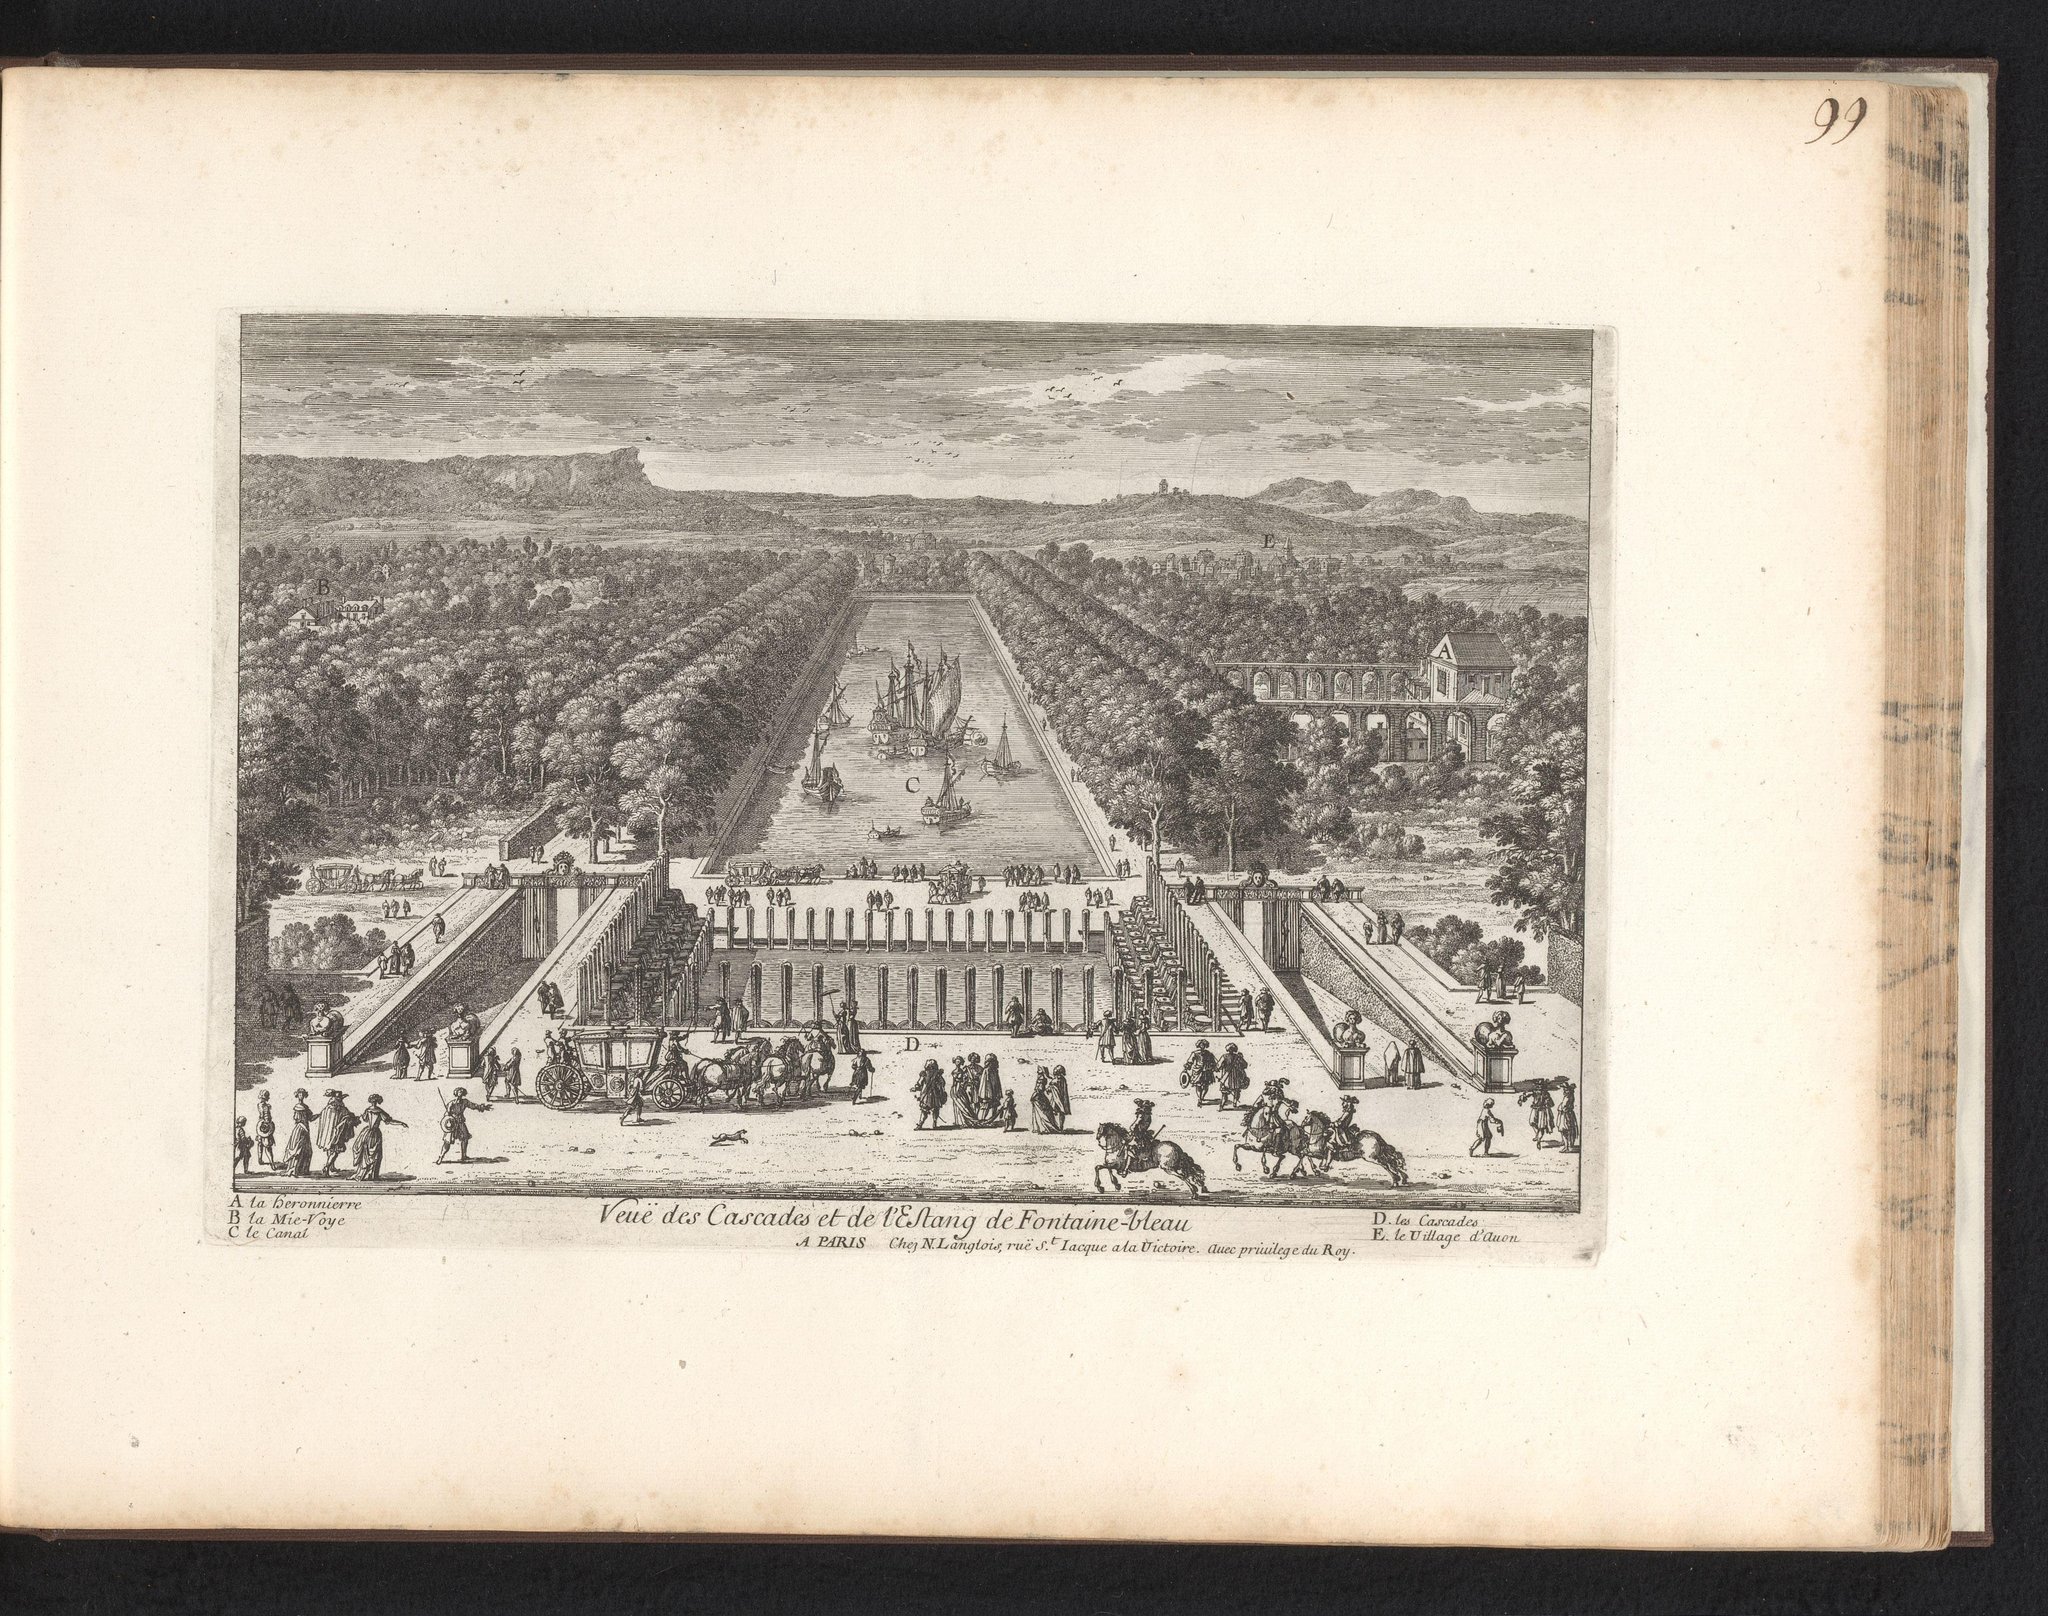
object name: album leaf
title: Gezicht op de watervallen van kasteel Fontainebleau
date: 1660-1703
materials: paper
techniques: etching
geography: france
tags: french or architectonic garden; formal garden, garden cascade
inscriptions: collector's mark: Lugt 2228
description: Prenten met het signatuur 'Perelle' kunnen zowel door vader Gabriel als door zonen Nicolas en Adam gemaakt zijn. De uitgevers vader en zoon Nicolas Langlois worden allebei vermeld als N. Langlois op hetzelfde adres.